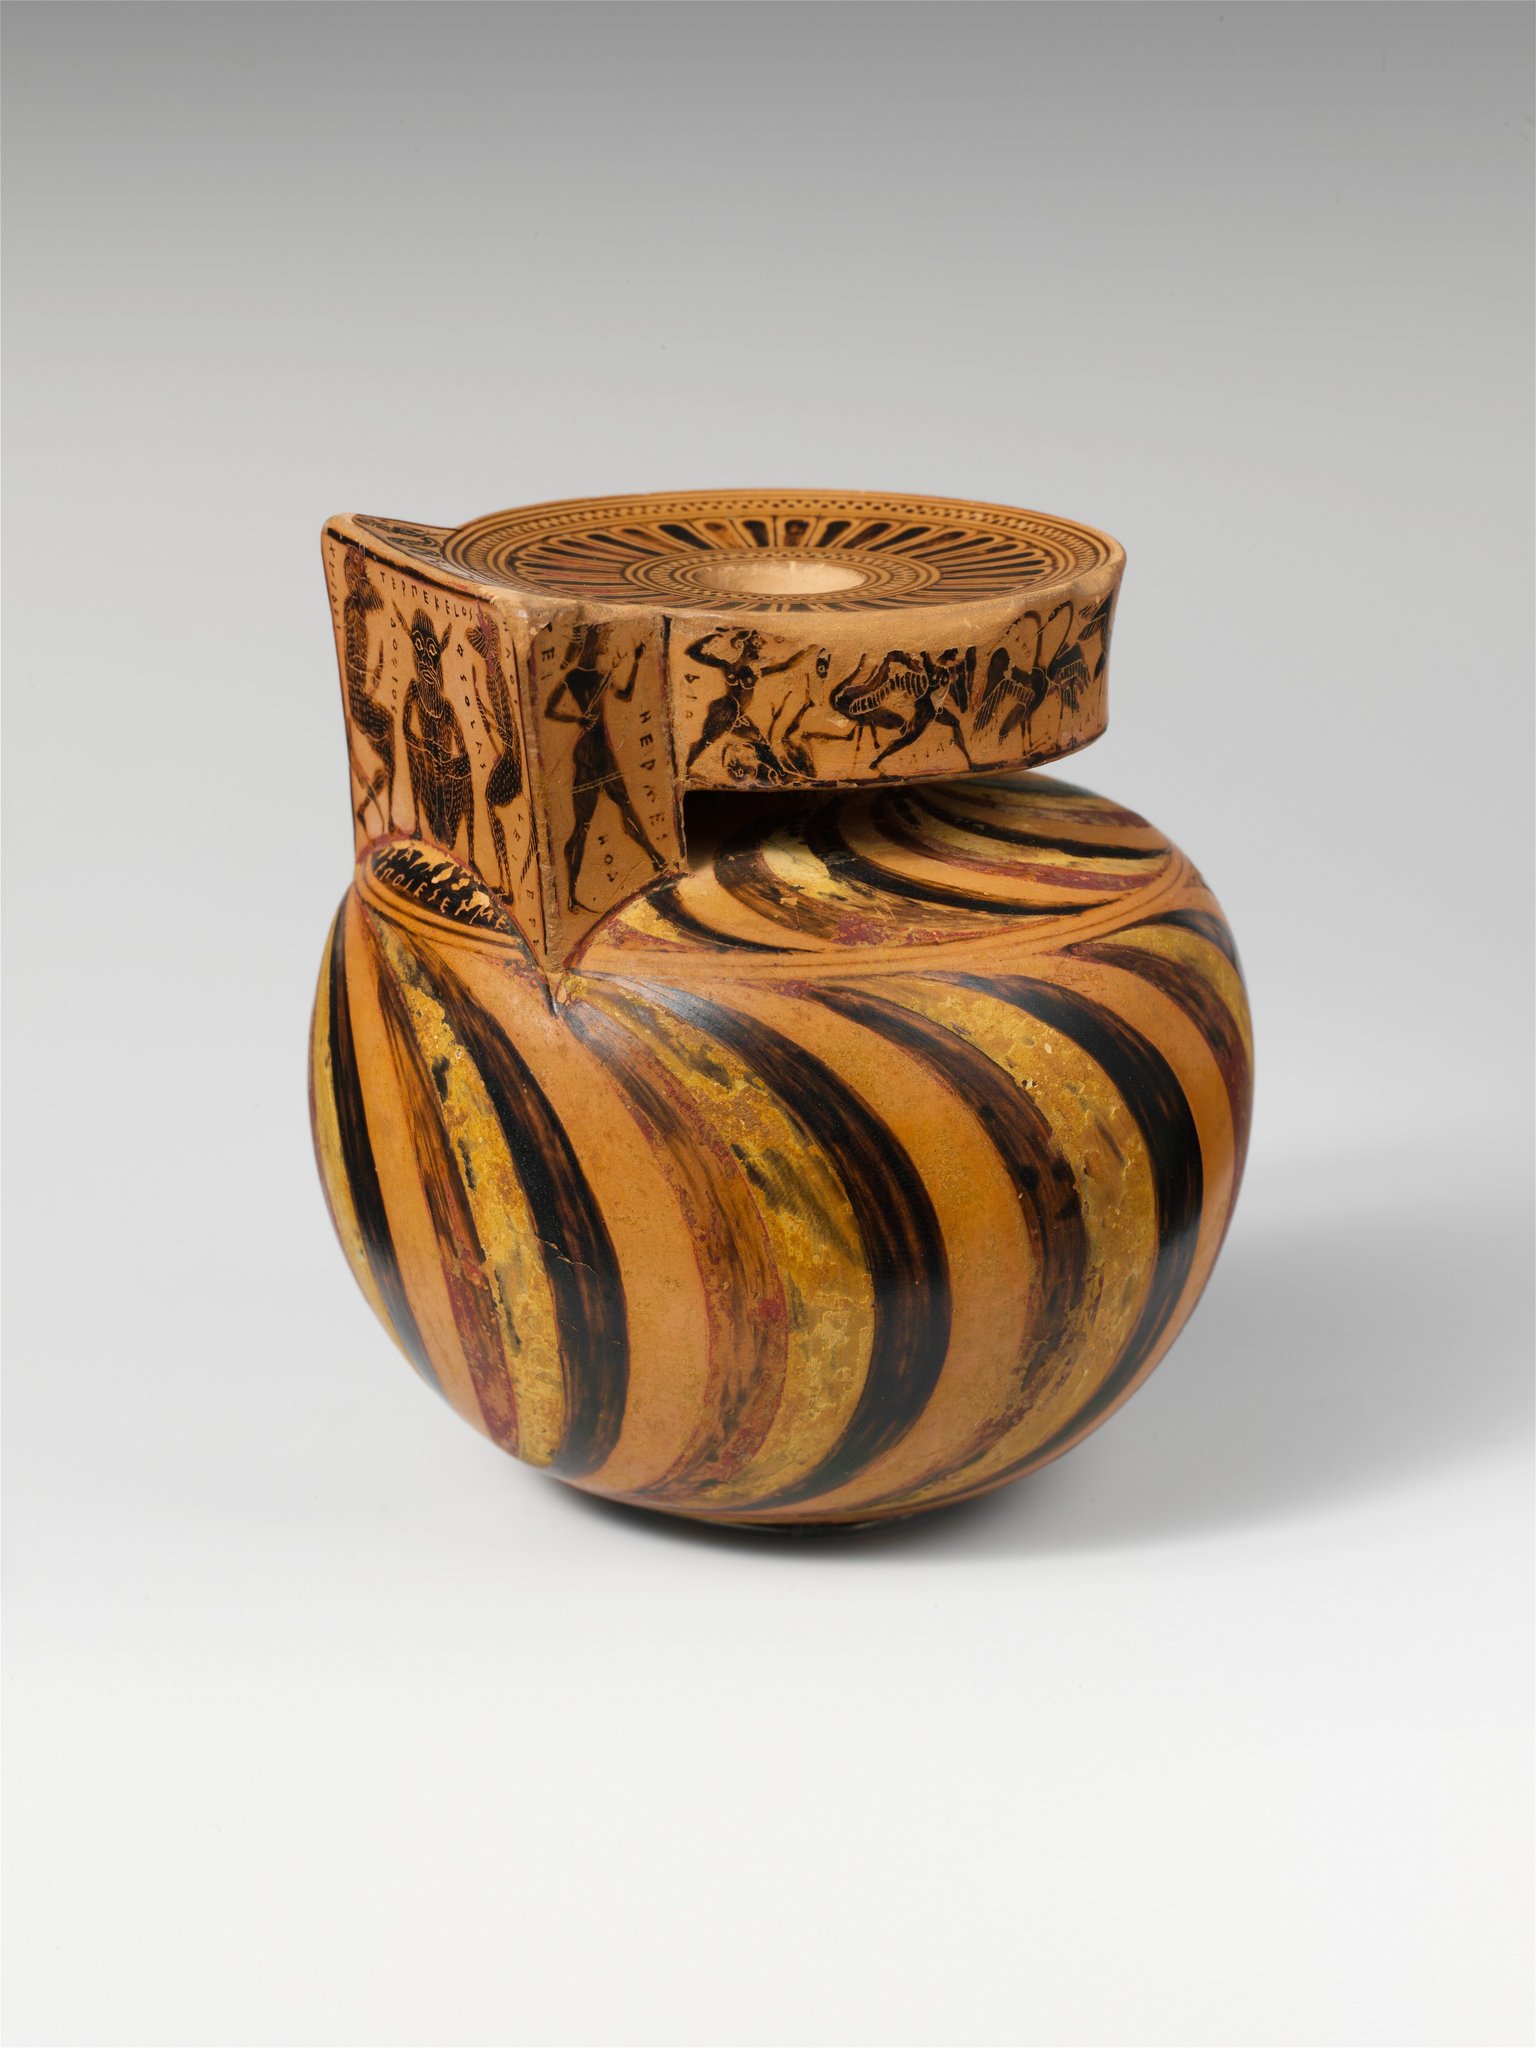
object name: aryballos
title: Terracotta aryballos (oil flask)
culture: greek, attic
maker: nearchos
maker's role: artist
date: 570 BCE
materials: terracotta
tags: cranes,hermes,perseus,satyrs